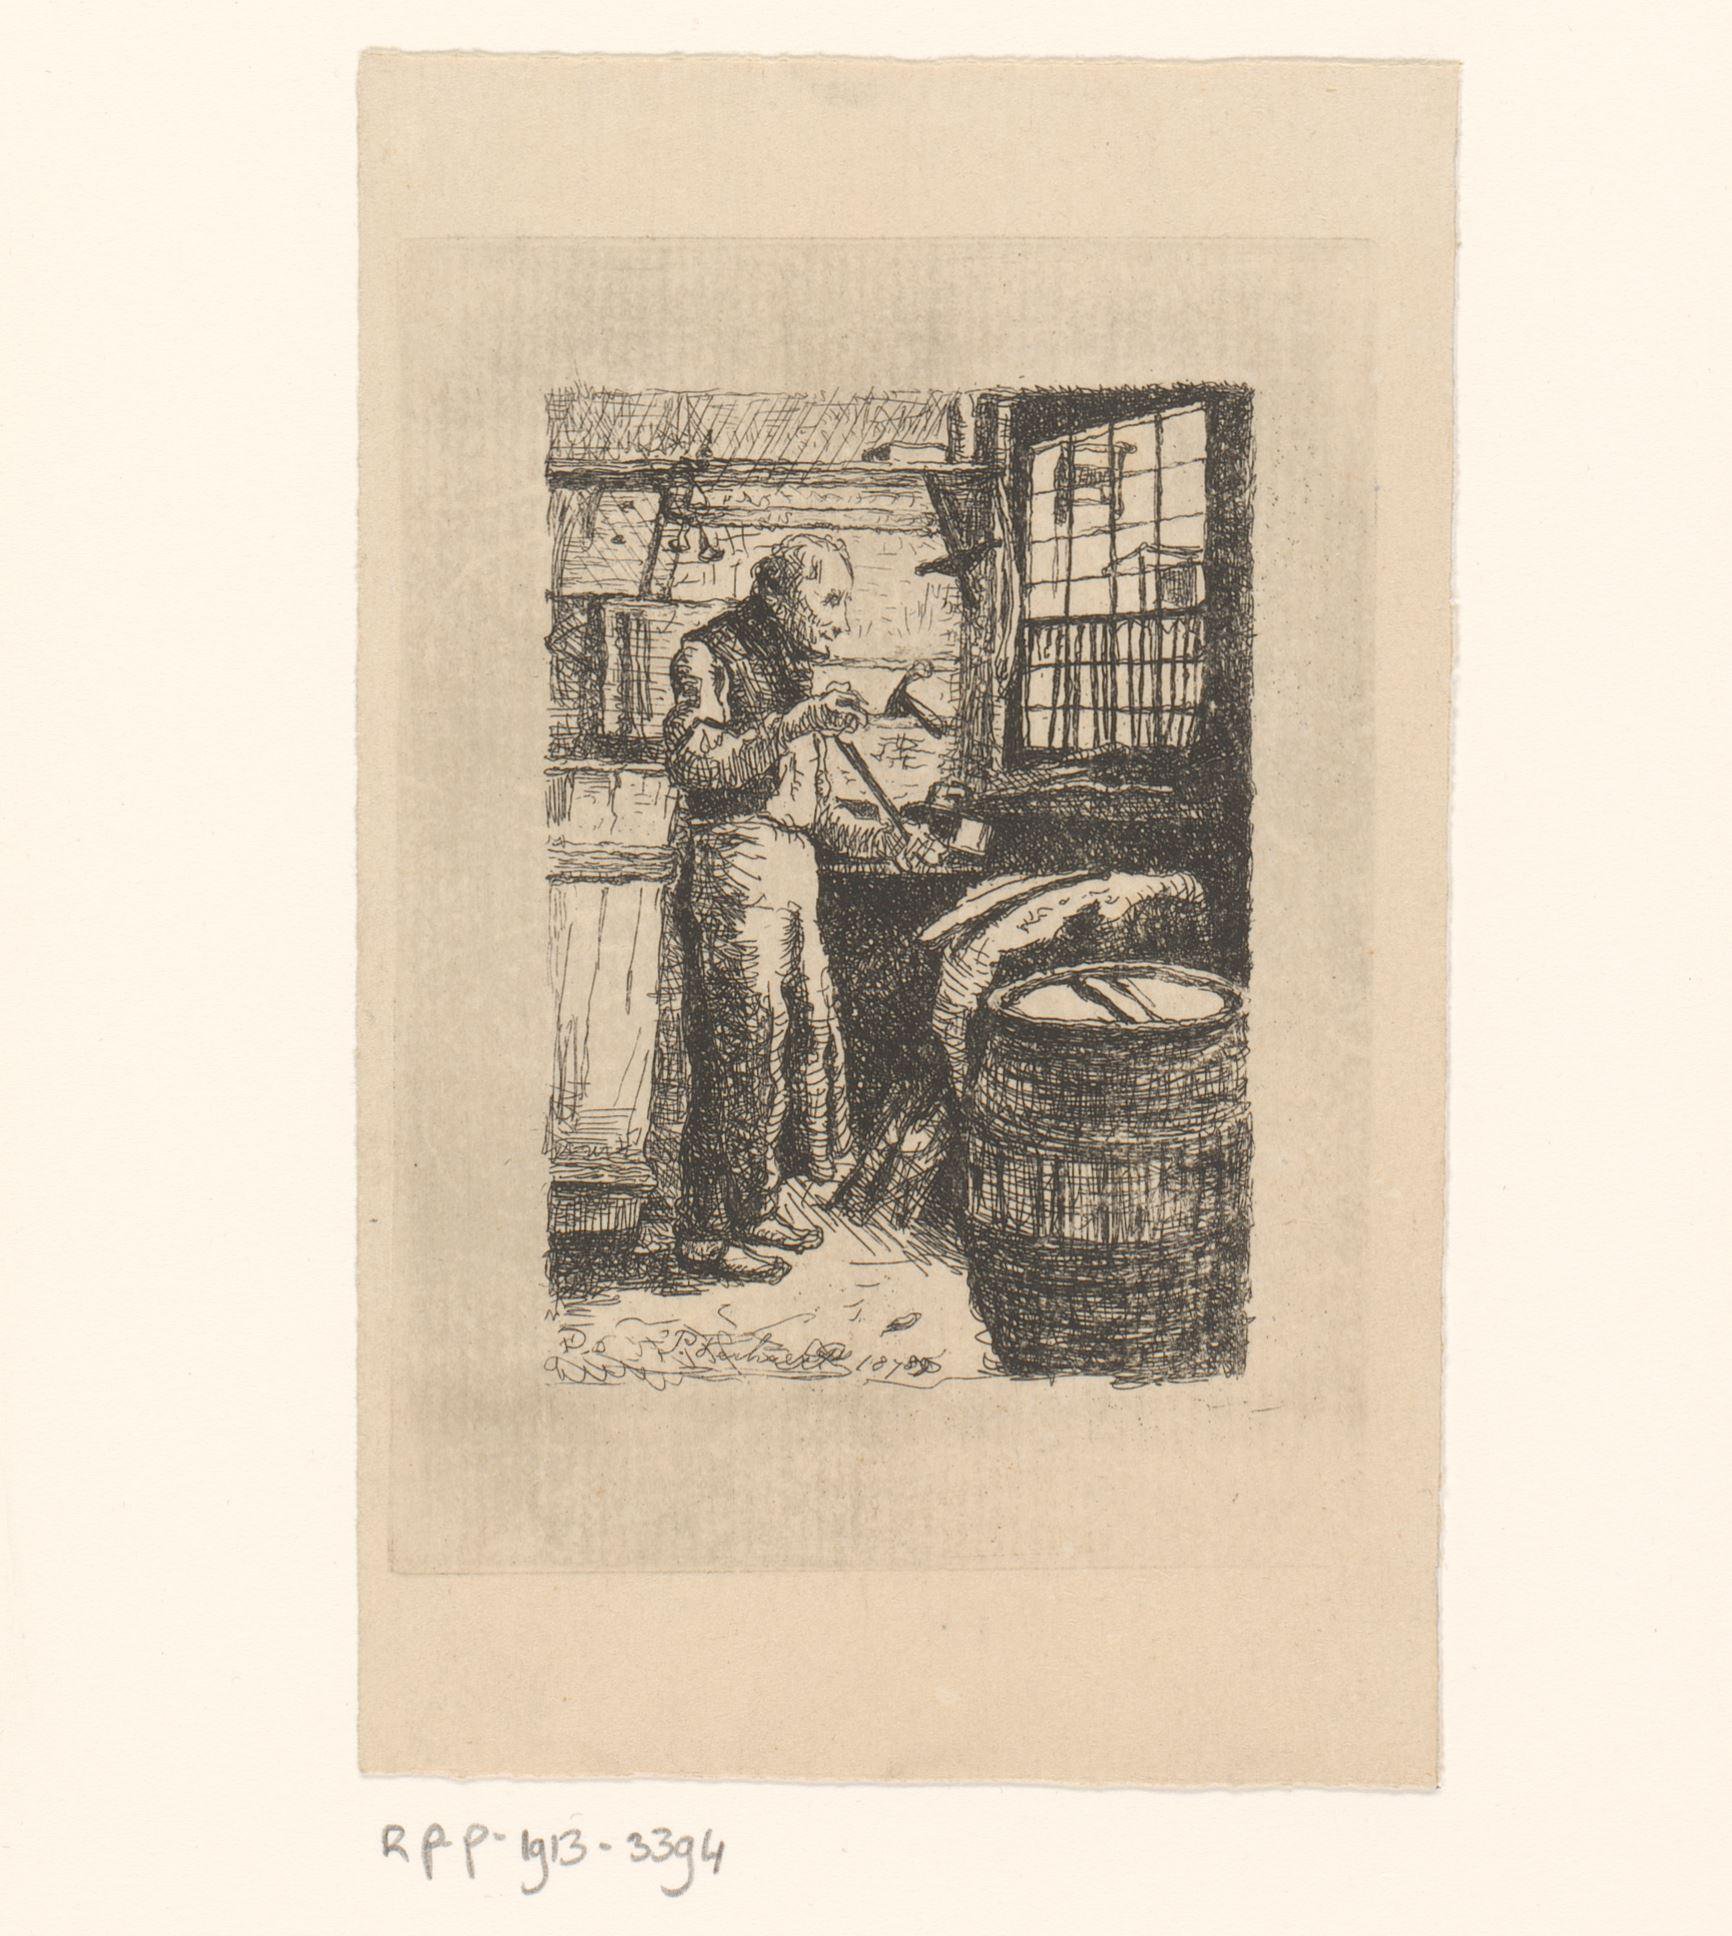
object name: print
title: Kuiper aan het werk in zijn werkplaats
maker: piet verhaert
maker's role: print maker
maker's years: 1852-1908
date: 1878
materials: paper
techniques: etching, intaglio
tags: handicrafts, craftsman at work, wooden container: barrel, cask, bucket, workshop-interior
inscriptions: collector's mark: Lugt 2228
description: Dezelfde voorstelling heeft Verhaert ook in groter formaat gemaakt.